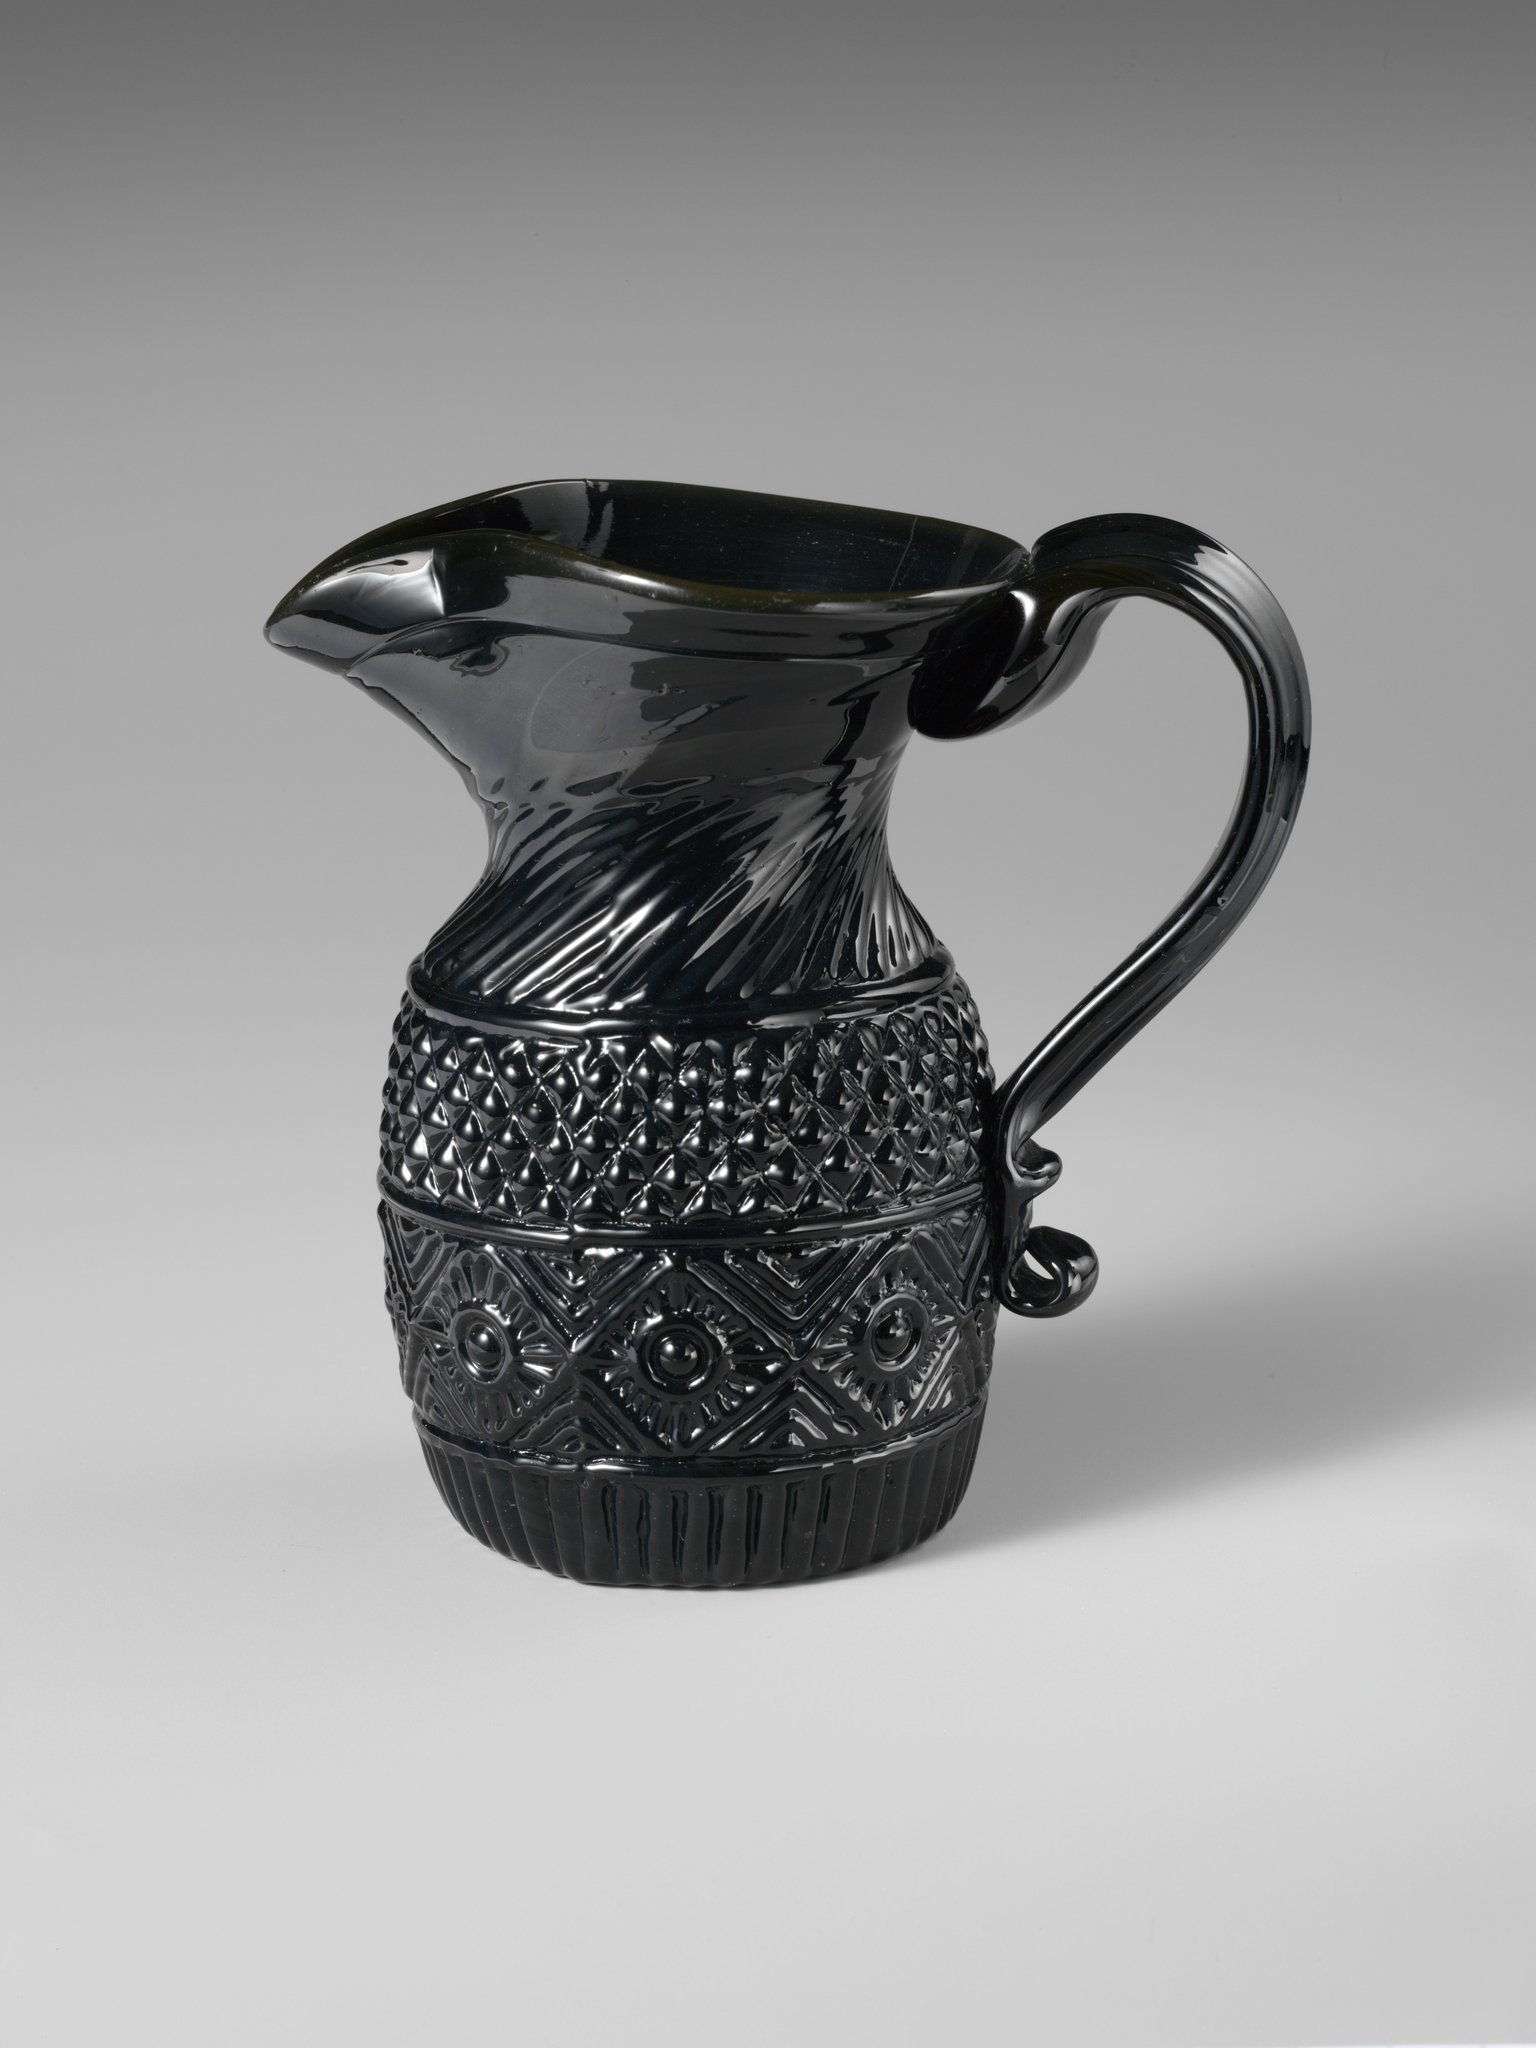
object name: pitcher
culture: american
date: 1820-1840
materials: glass, lead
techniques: glassblowing, molding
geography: united states